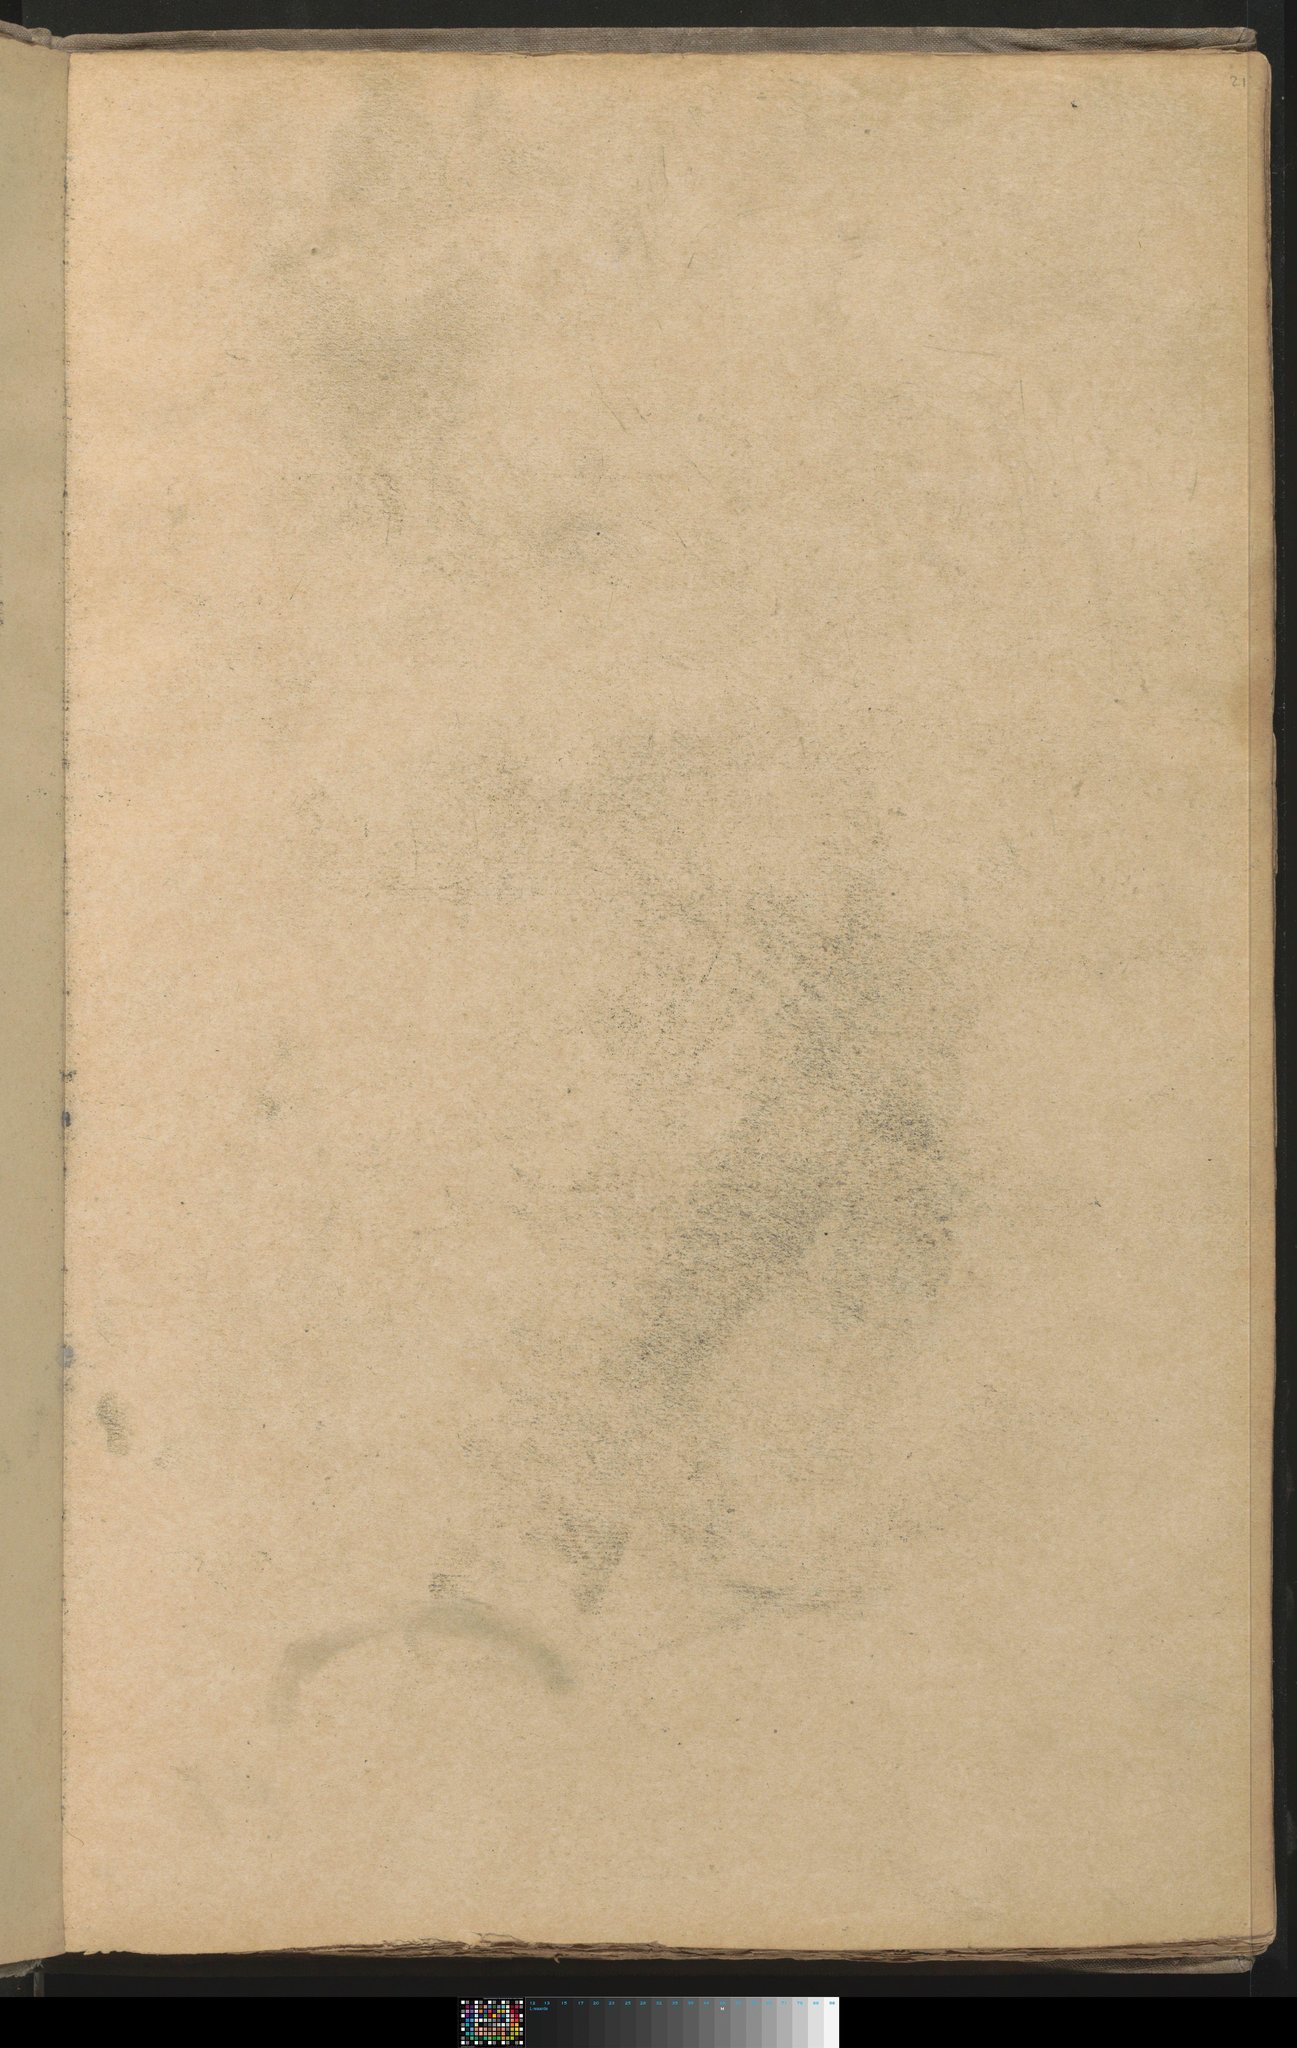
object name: sketchbook leaf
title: Abklatsch van de tekening op pagina 20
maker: willem witsen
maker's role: draughtsman, painter, print maker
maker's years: 1860-1923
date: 1884-1887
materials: paper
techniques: printmaking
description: Pagina 21 uit een schetsboek met 42 bladen vervaardigd rond de Ewijkshoeve.